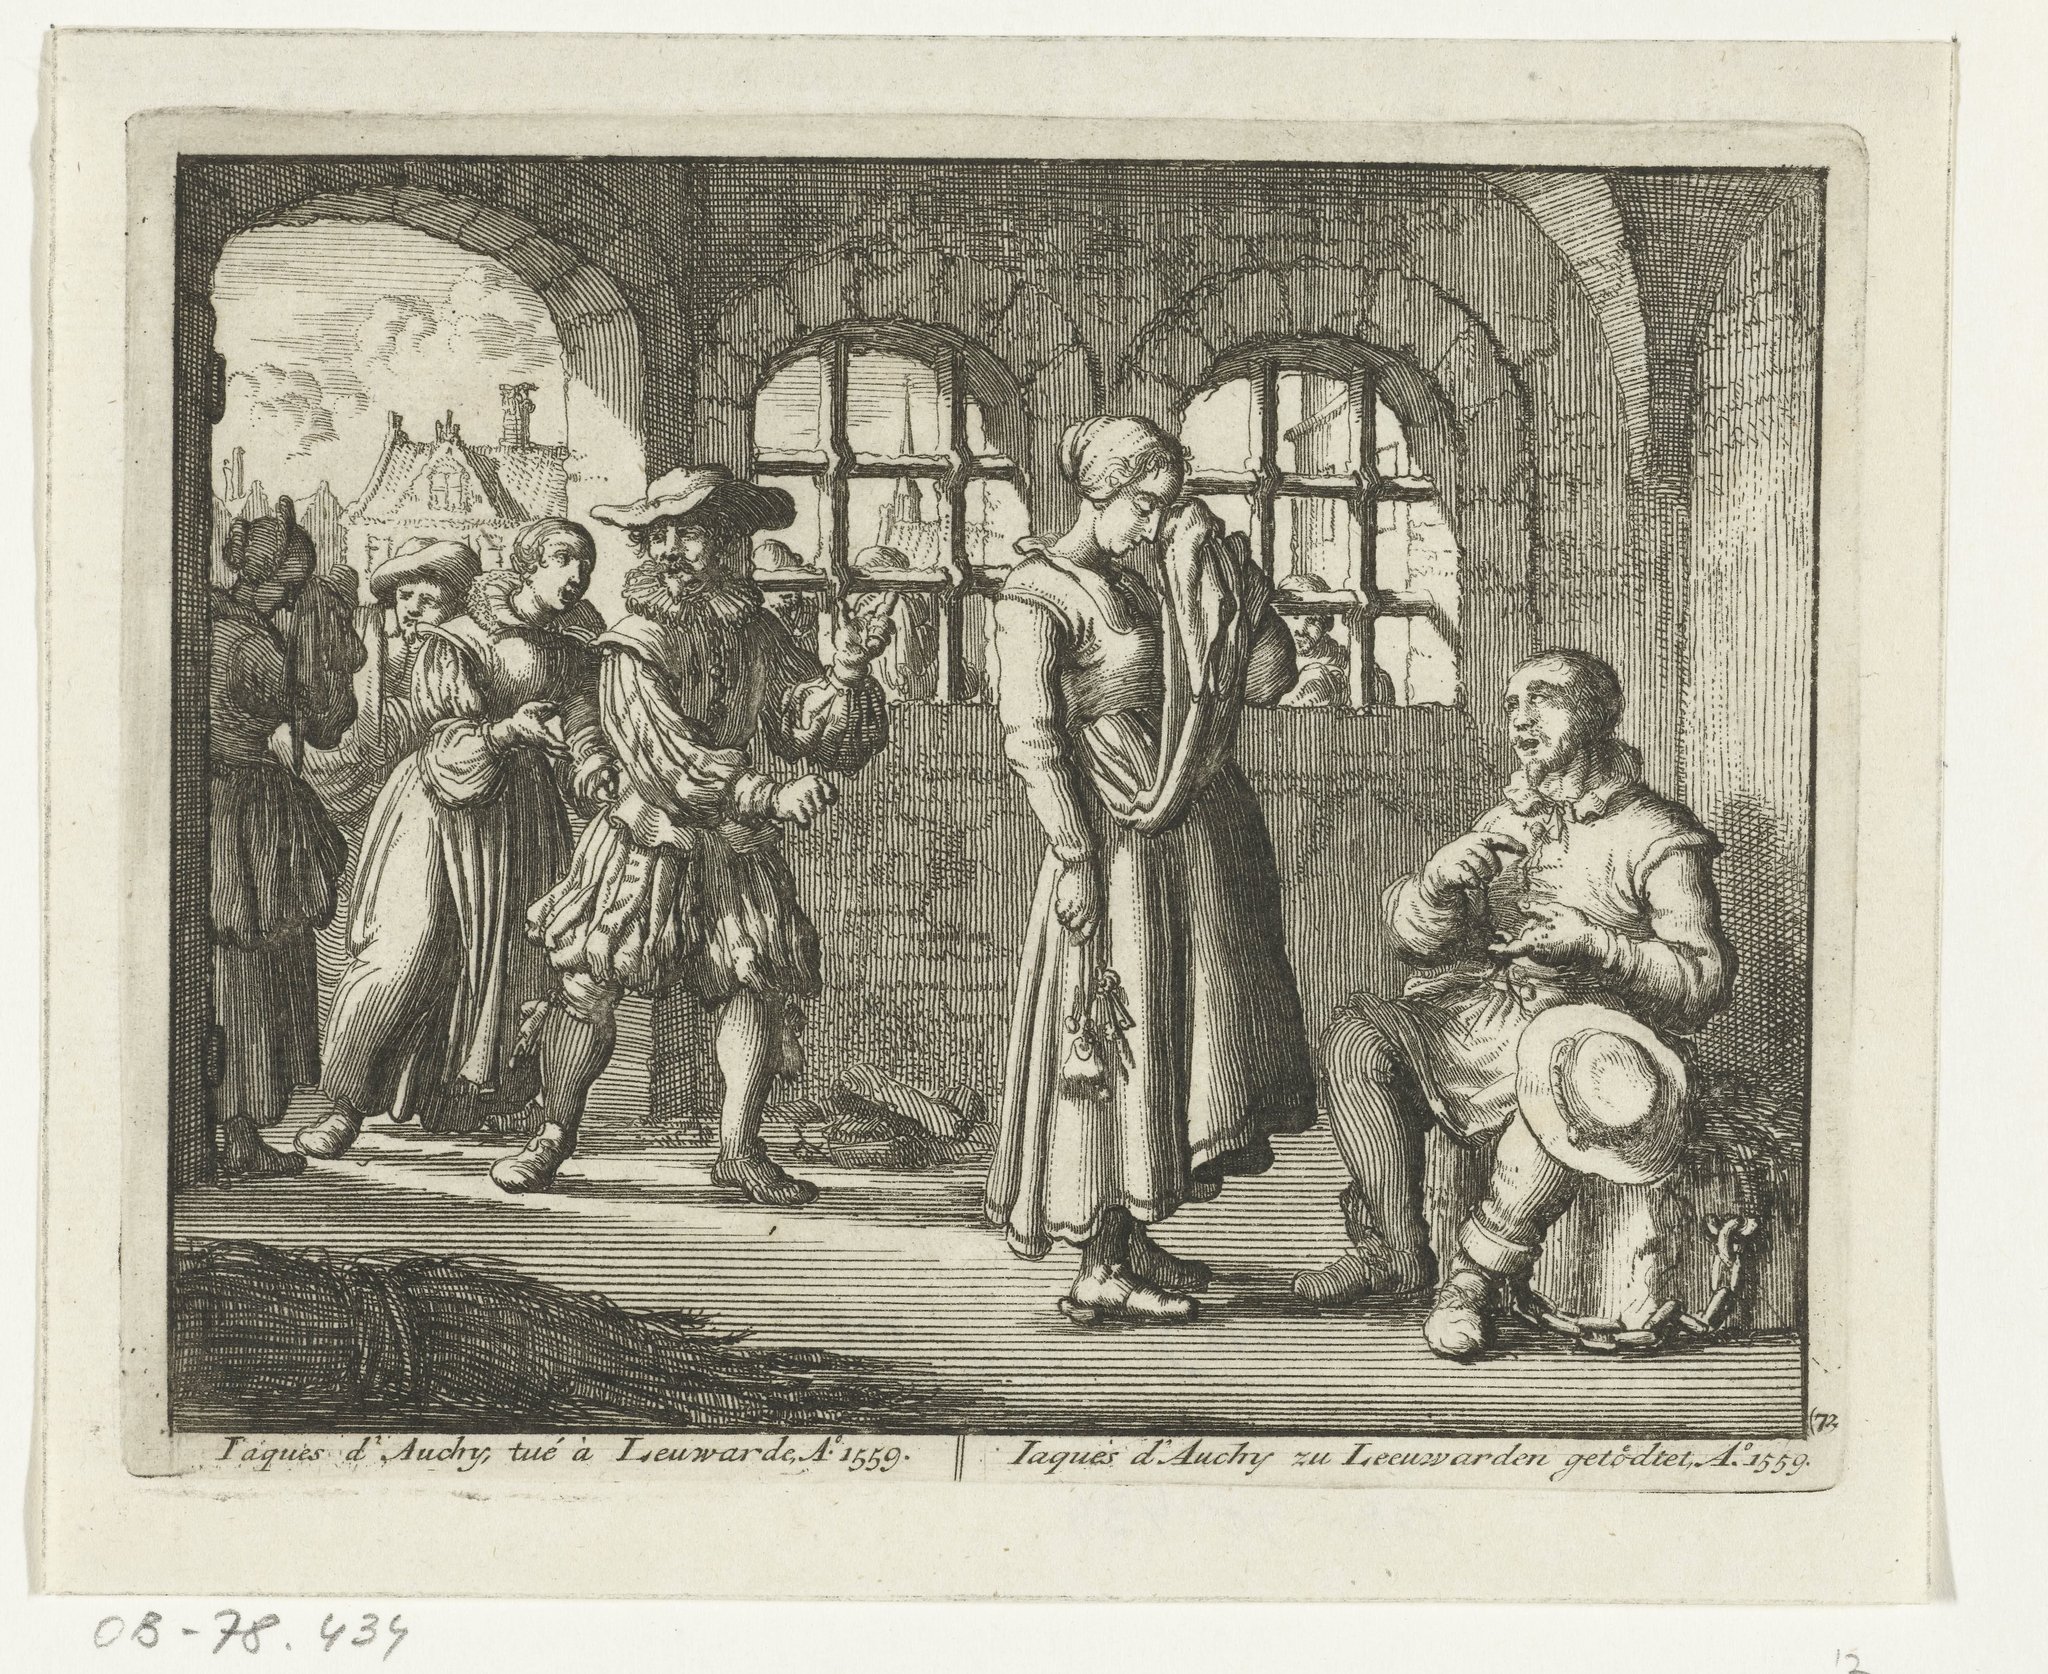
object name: history print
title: Jaques d'Auchy neemt in de gevangenis te Leeuwarden afscheid van zijn vrouw, 1559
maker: jan luyken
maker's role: draughtsman, print maker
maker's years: 1649-1712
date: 1683-1685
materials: paper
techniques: etching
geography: northern netherlands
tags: persecution of heretics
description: De prenten in deze tweede staat gebruikt als illustratie voor: Theatre des martyrs, depuis la mort de J. Christ jusqu'à present (...). = Schau-buhne der Martyrer, P. van der Aa, Leiden ca. 1715, nr. 72. De prenten zijn oorspronkelijk vervaardigd voor en eerst gebruikt in: T.J. van Bragt, Het bloedig tooneel, of Martelaers spiegel der doops-gesinde of weereloose christenen, 1685.